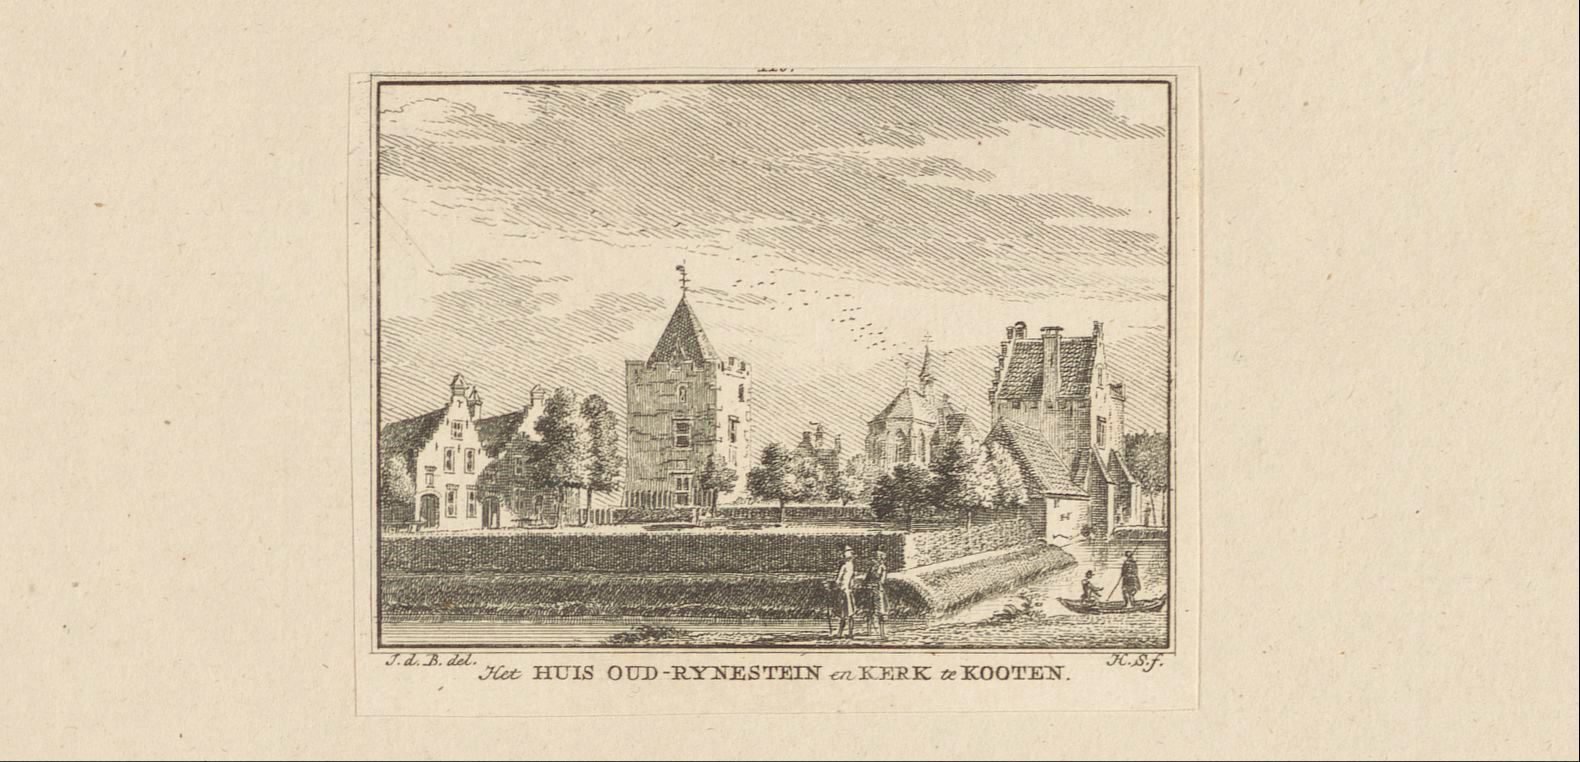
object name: print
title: Het huis Oud-Rynestein en kerk te Kooten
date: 1773-1792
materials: paper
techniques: engraving, etching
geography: haarlem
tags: castle, church (exterior)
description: Prent ook gebruikt in: Het verheerlykt Nederland of kabinet van hedendaagsche gezigten van steden, dorpen (…). 9 delen. Amsterdam: Isaak Tirion en weduwe Isaak Tirion, 1745-1774, dl. 7, 8 of 9 (weduwe Isaak Tirion, 1773-1774), ill. 116. Of in: Nederlandsche tafereelen; of eene keurige verzameling van negen honderd fraaije gezigten van steden, dorpen, sloten, oudheden (….). 9 delen. Amsterdam: Jan de Groot, 1792, dl. 7, 8 of 9, ill. 116. Uit welke druk het huidige exemplaar precies komt is niet na te gaan.